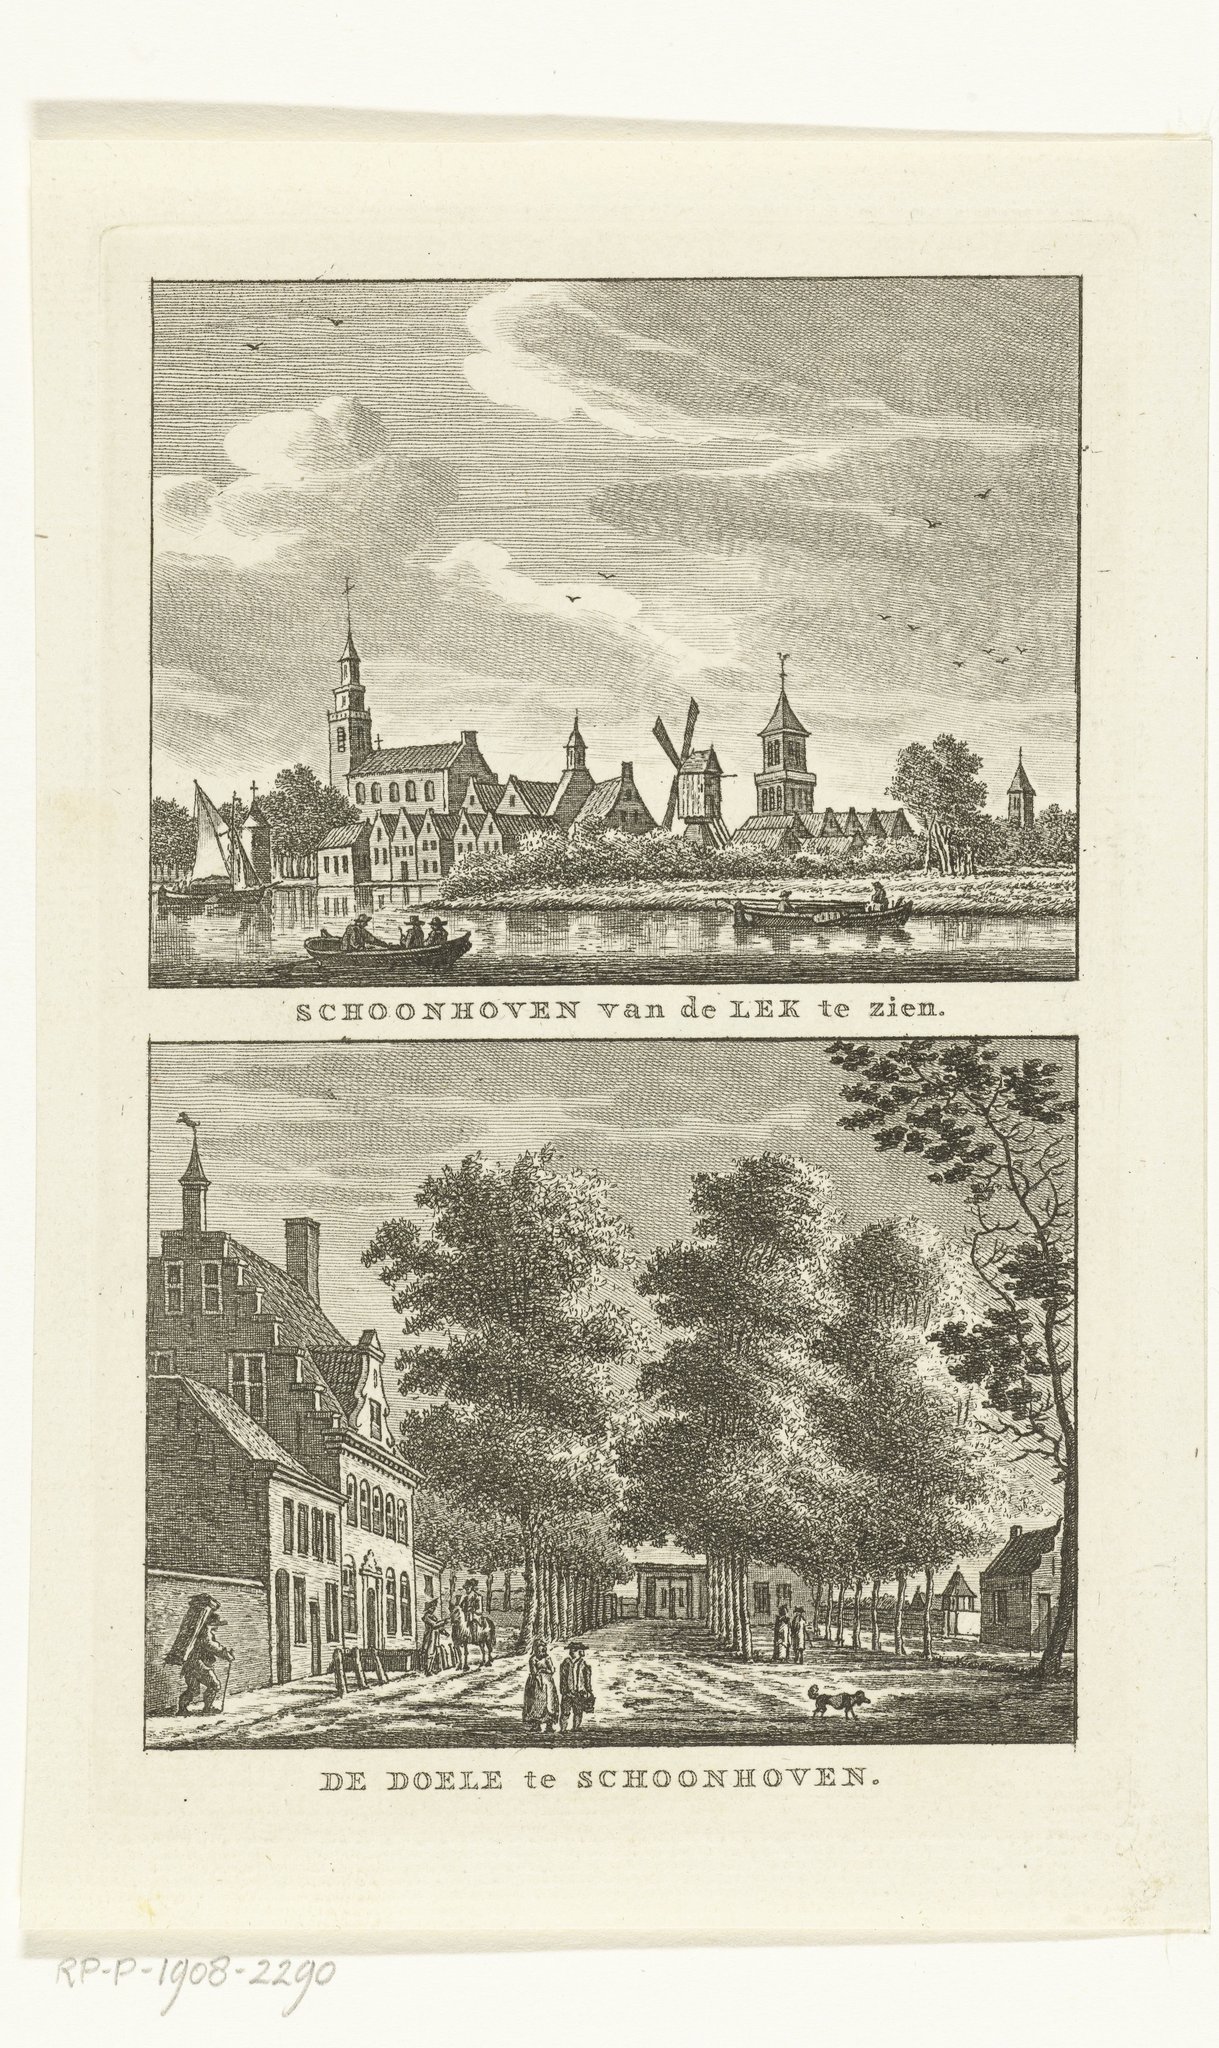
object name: print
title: De Doele te Schoonhoven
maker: carel frederik bendorp (i)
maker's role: print maker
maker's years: 1736-1814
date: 1786-1792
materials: paper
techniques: etching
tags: village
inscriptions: collector's mark: Lugt 2228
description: Prent uit: Vaderlandsche gezichten, of afbeeldingen van den tegenwoordigen staat der Vereenigde Nederlanden (…). Amsterdam: Hendrik Gartman, Willem Vermandel en Jan Willem Smit, 1786-1792. Uitgegeven in afleveringen met ieder een eigen bifolium en inhoudsopgave. Alle prenten in deze publicatie zijn gegraveerd door Carel Frederik Bendorp (I) en, in de meeste gevallen, gebaseerd op tekeningen van Jan Bulthuis.